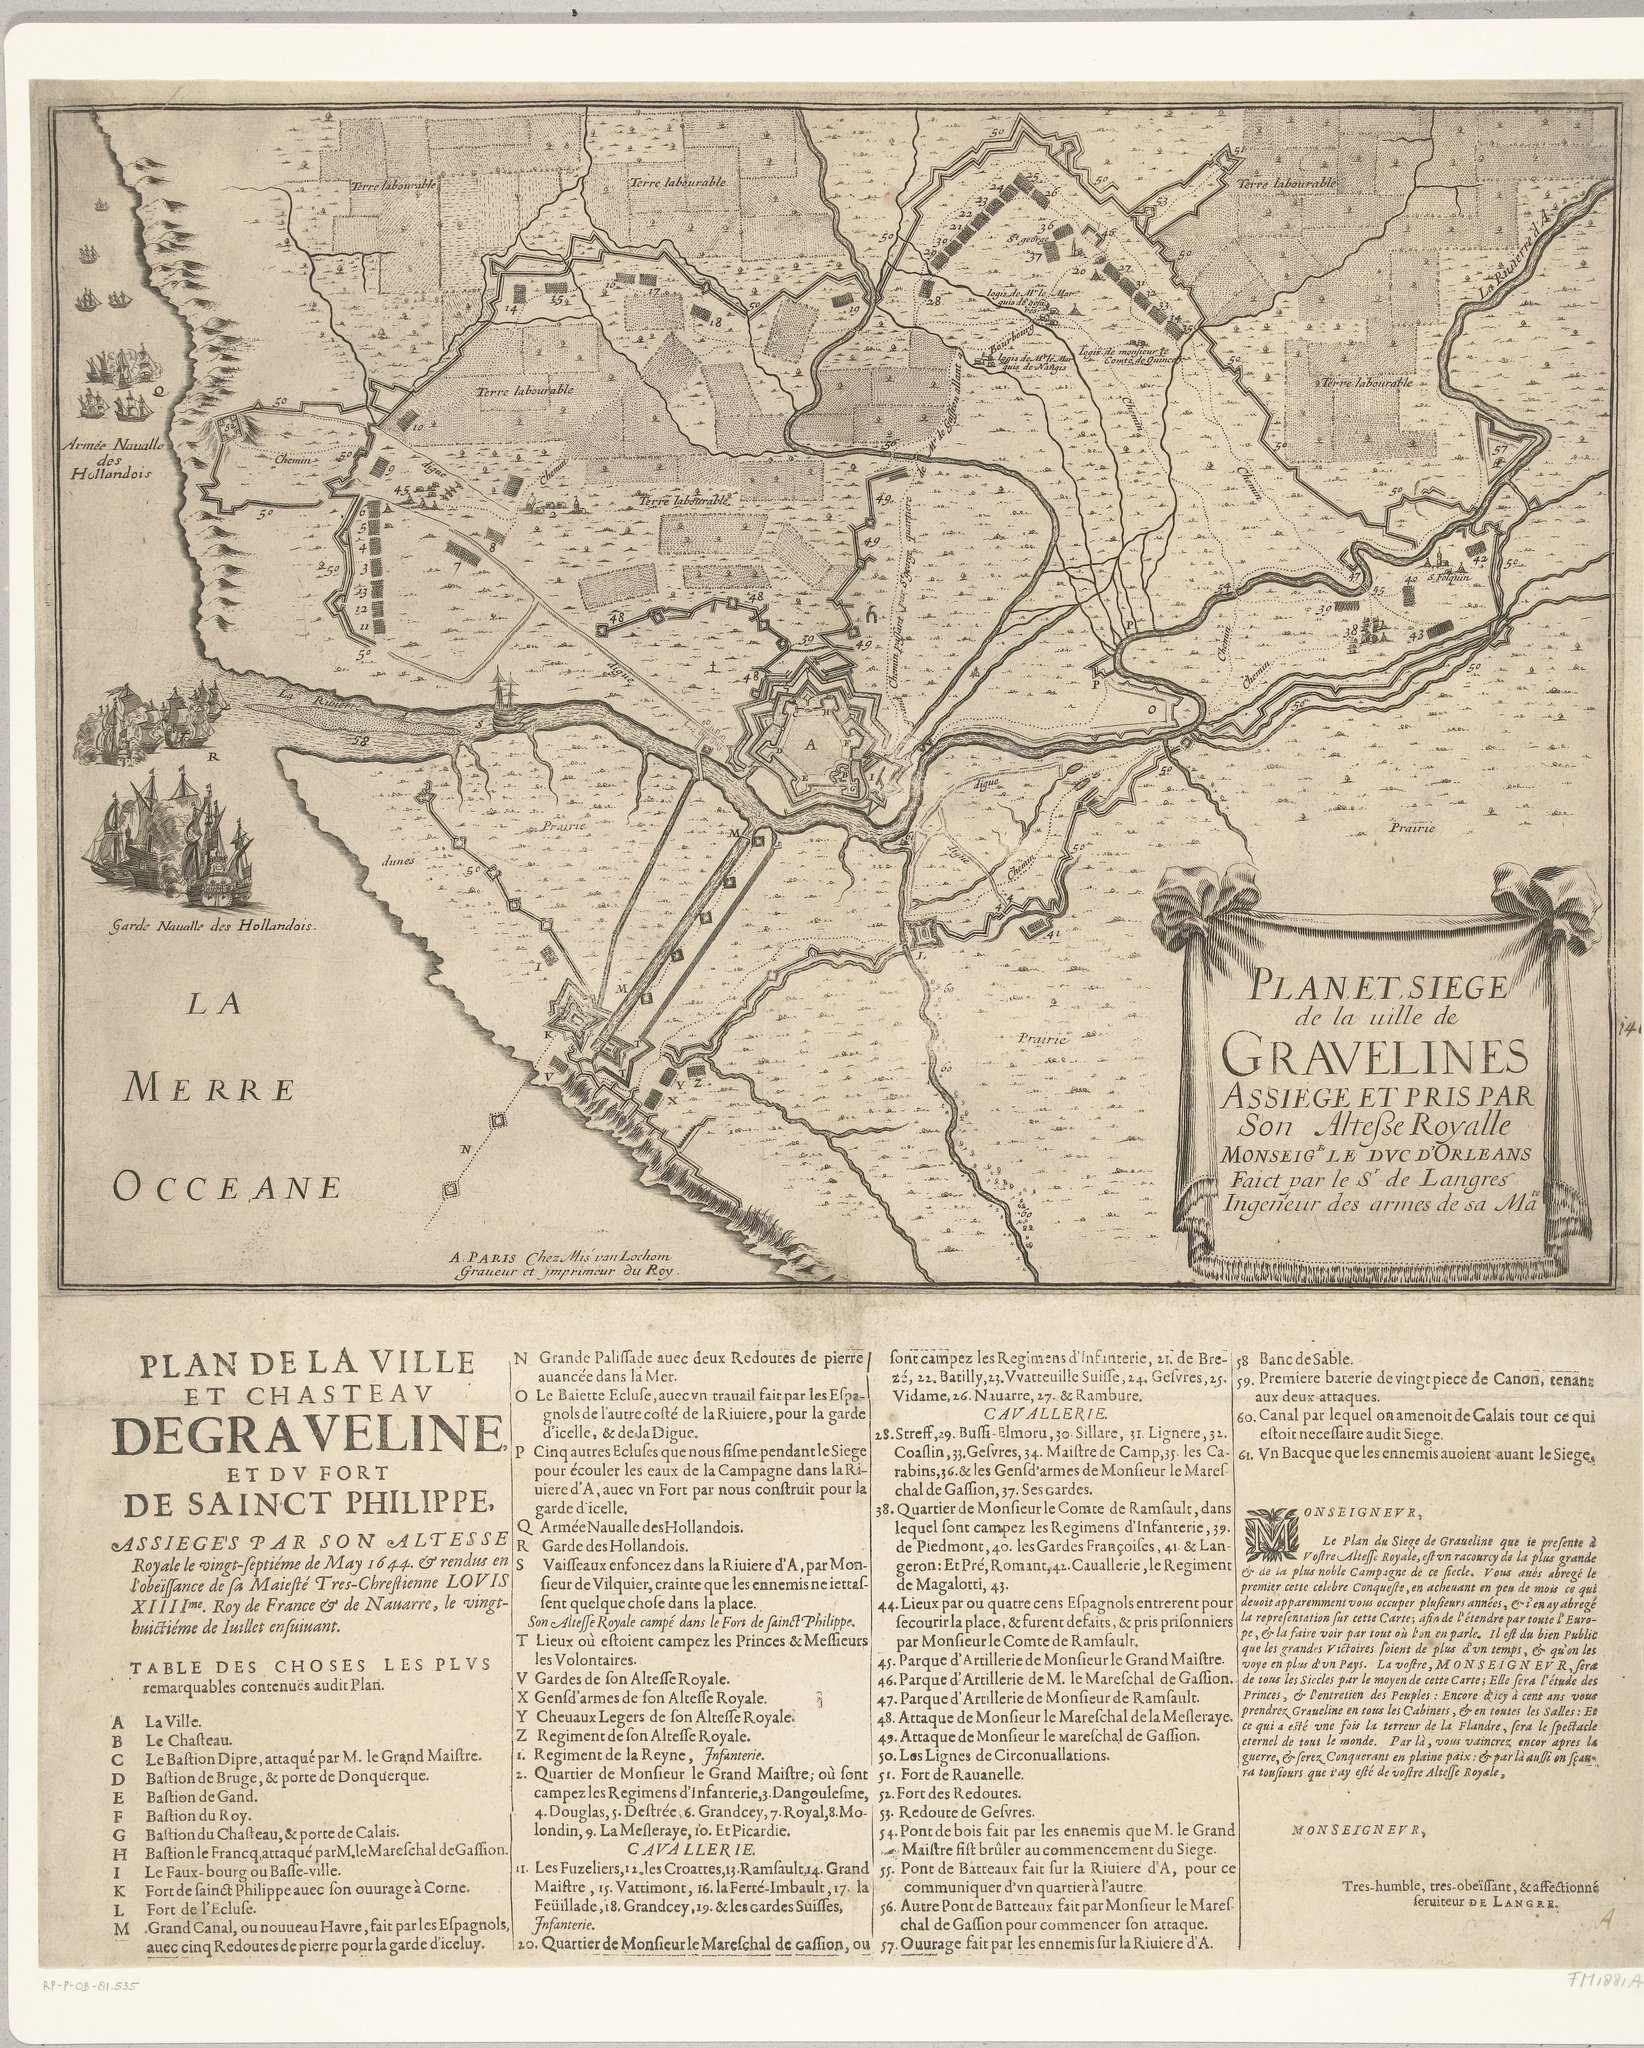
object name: print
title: Kaart van beleg en verovering van Grevelingen, 1644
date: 1644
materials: paper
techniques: etching, letterpress printing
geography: paris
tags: gaston jean-baptiste hertog van orléans, maps of separate countries or regions, siege, position war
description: Kaart van het beleg en de verovering van de stad Grevelingen door het Franse leger onder Gaston hertog van Orléans, 27 mei - 28 juli 1644. Plan van de versterkte stad met het omliggende land, links de haven geblokkeerd door Hollandse schepen. Onder de prent is een tekstblad geplakt met de legenda A-Z en 1-61 in het Frans.